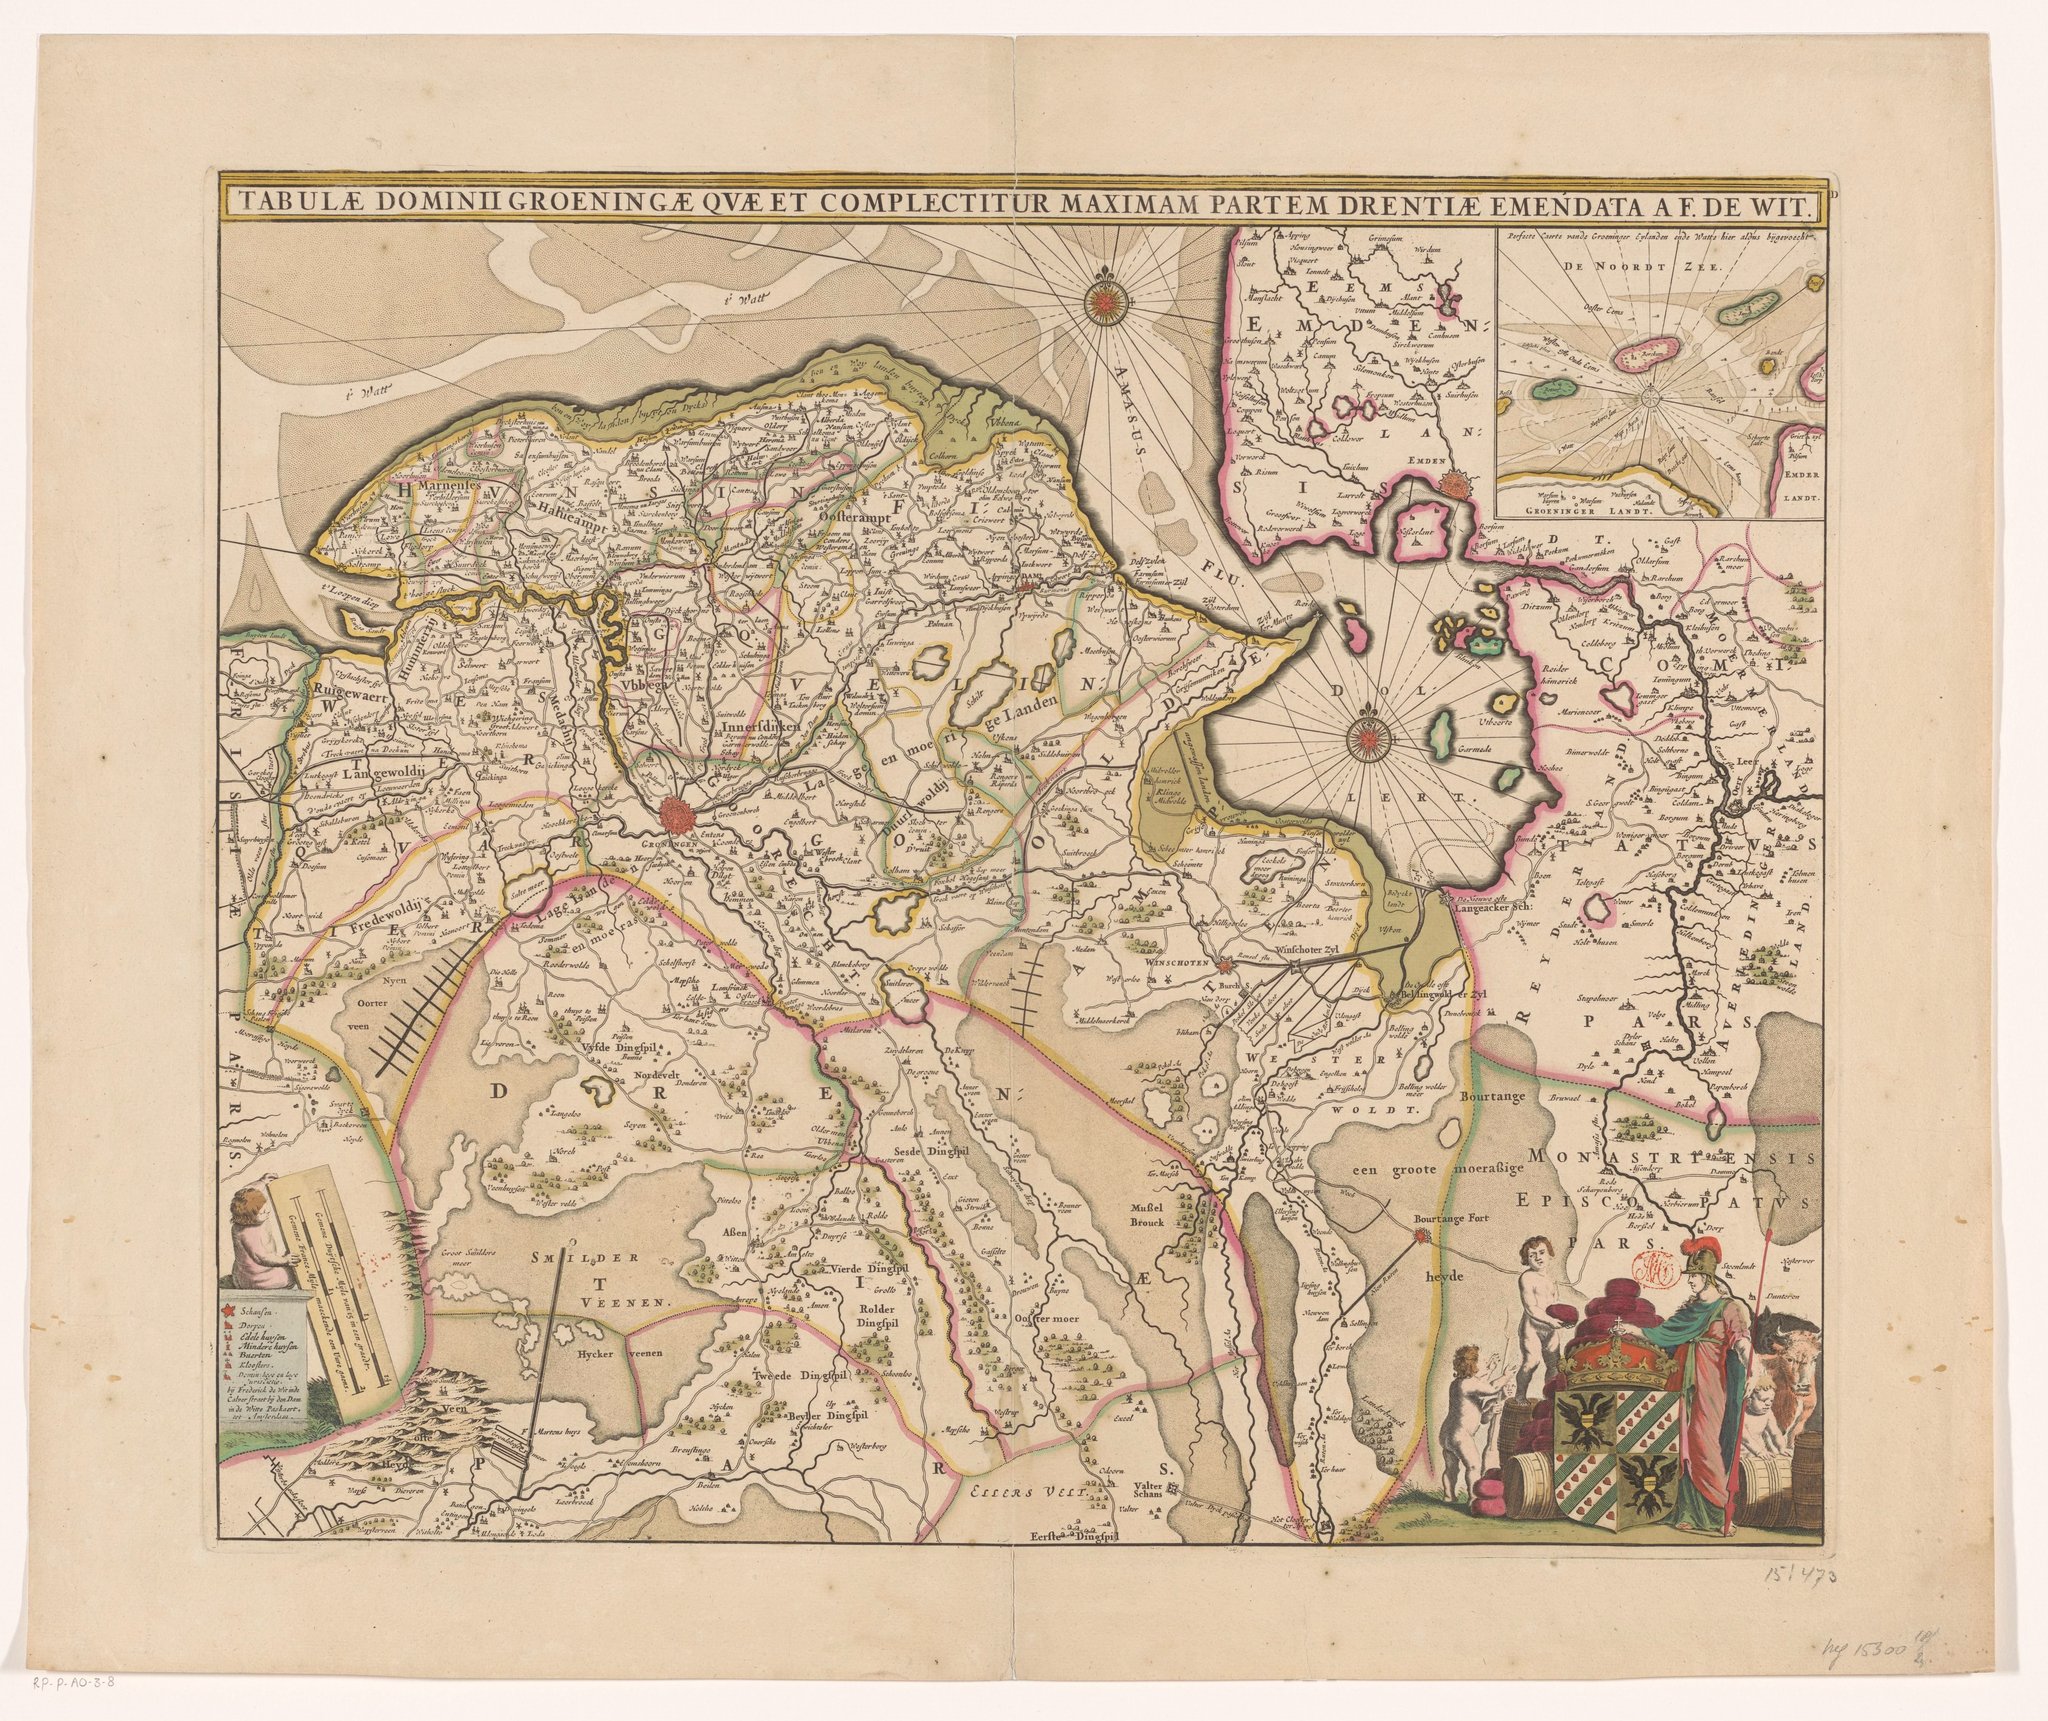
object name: print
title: Kaart van de provincie Groningen en een deel van Drenthe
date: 1670-1672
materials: paper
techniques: engraving, etching, hand coloring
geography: amsterdam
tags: coat of arms (as symbol of the state, etc.), maps of separate countries or regions, (story of) minerva (pallas, athena), agriculture, cheese, groningen (province)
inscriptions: collector's mark: Lugt 2228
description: Linksonder legenda en twee schaalstokken: Gemene Duijtsche mijle van 15 in een graedt, Gemene France mijle maeckende een uure gaens. Rechtsboven inzetkaart van het Waddengebied. Rechtsonder het wapen van de provincie Groningen, daaromheen jongens, kazen, vee en Minerva.